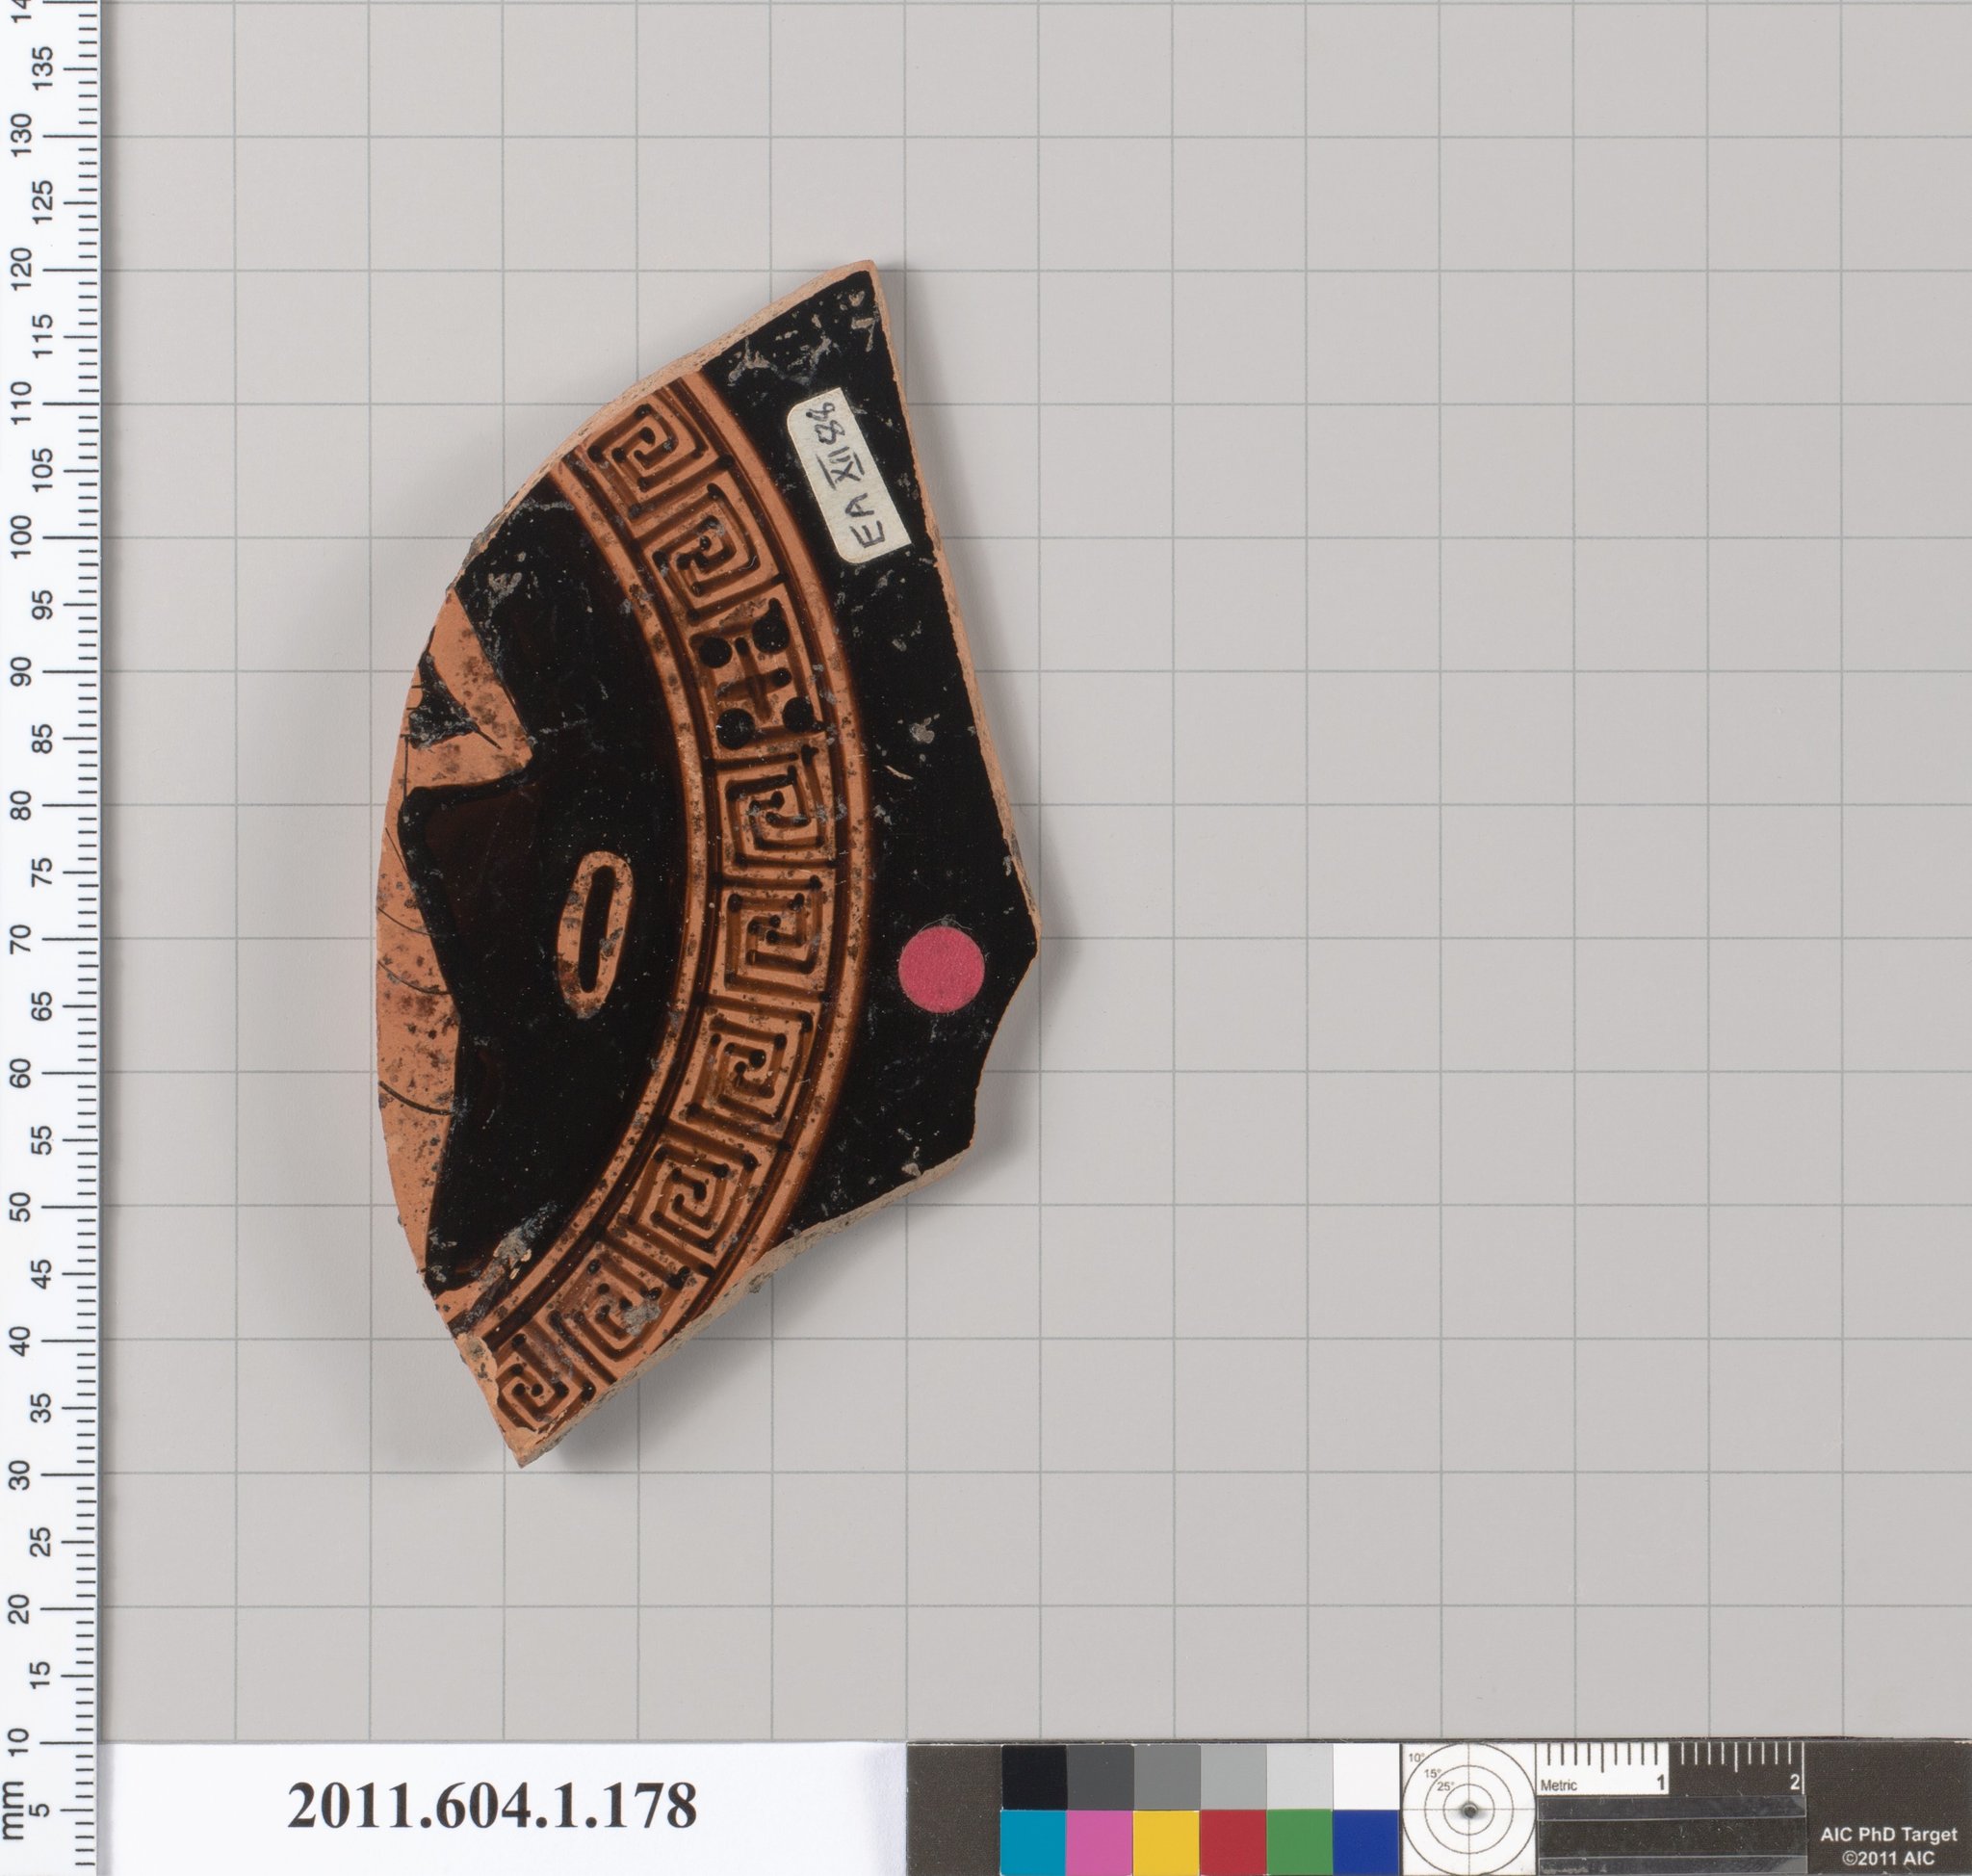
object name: kylix fragment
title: Terracotta fragment of a kylix (drinking cup)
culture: greek, attic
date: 475-451 BCE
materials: terracotta